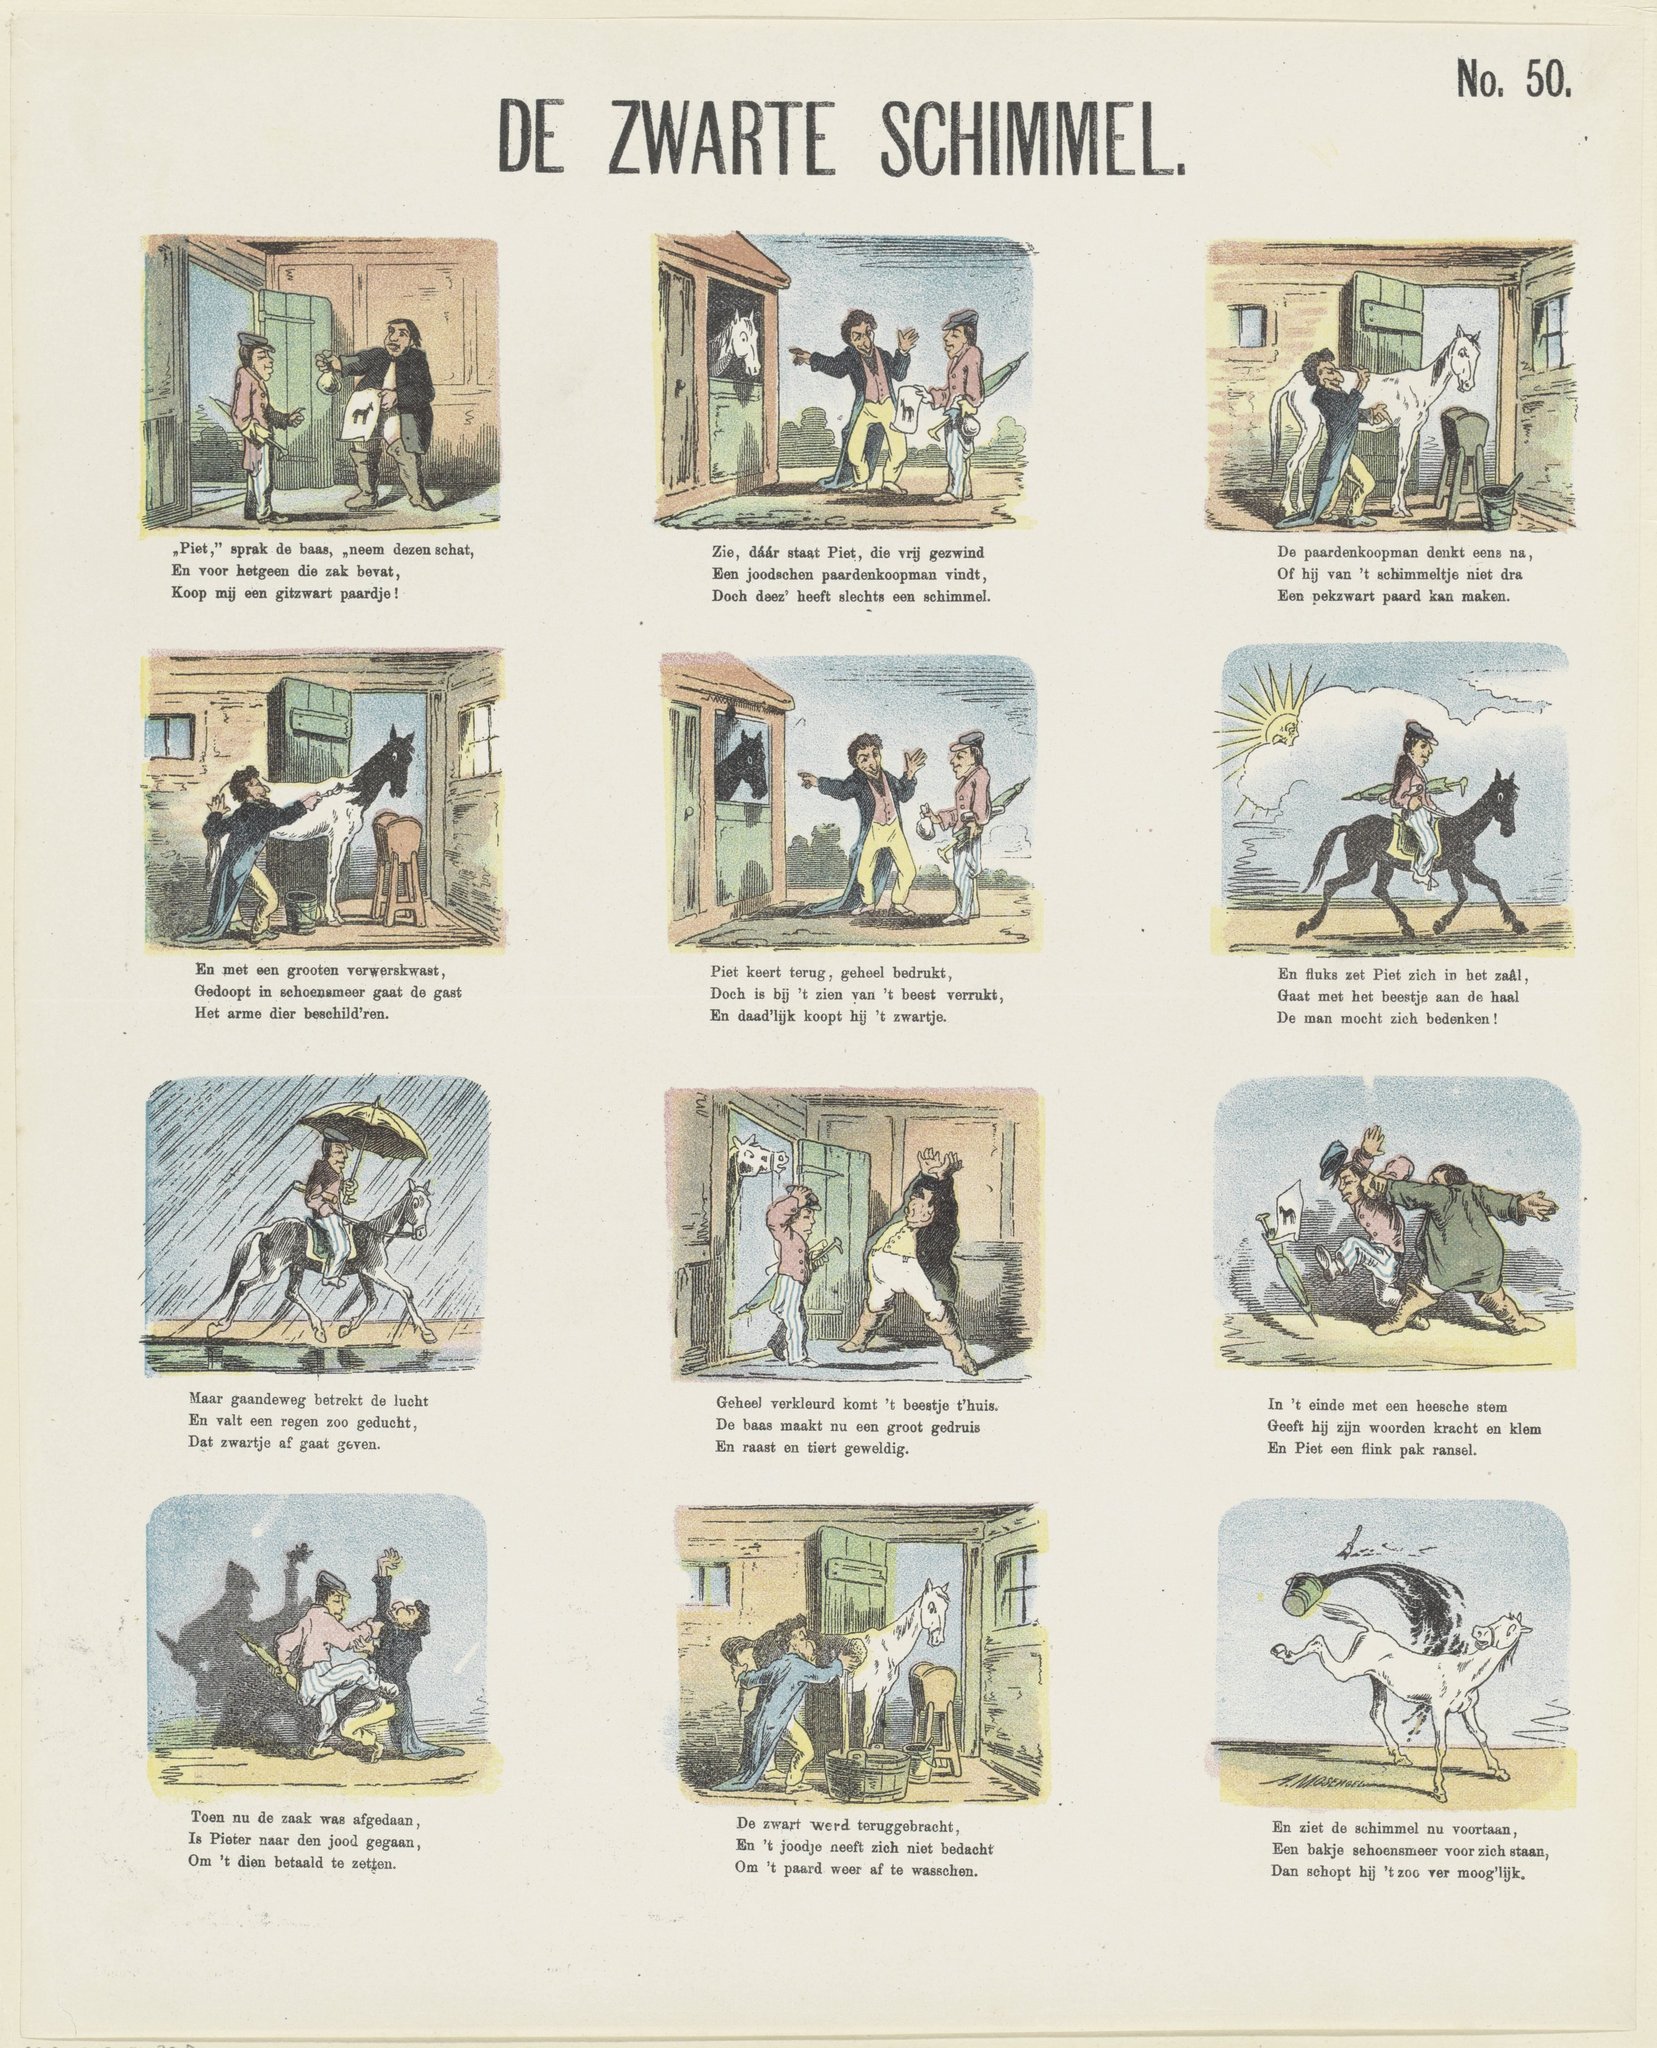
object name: print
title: De zwarte schimmel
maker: Anonymous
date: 1878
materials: paper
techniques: lithograph, letterpress printing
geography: amsterdam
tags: horse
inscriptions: collector's mark: Lugt 2760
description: Blad met 12 komische voorstellingen over een joodse paardenkoopman die een schimmel zwart verft. Het bedrog komt uit na een regenbui. Onder elke afbeelding een drieregelig onderschrift. Genummerd rechtsboven: No. 50.